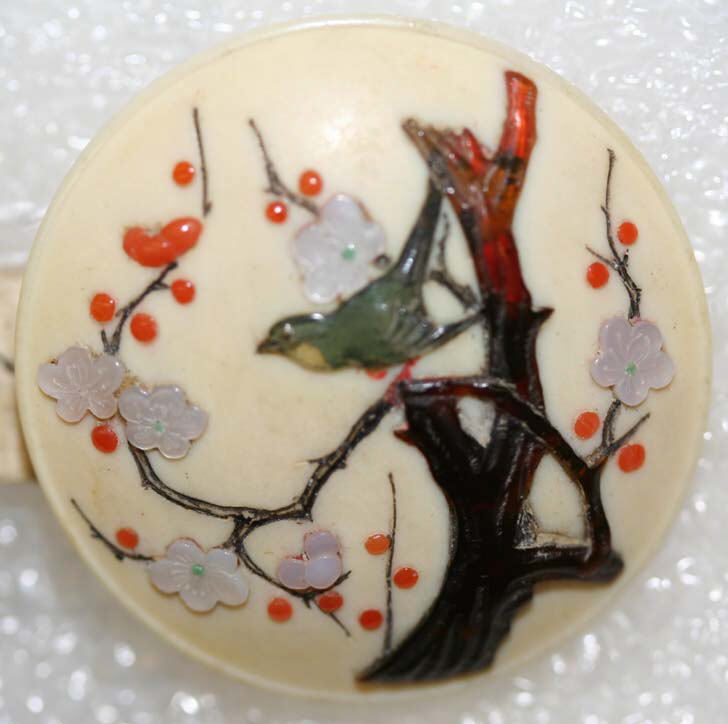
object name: button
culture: japanese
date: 1850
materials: coral, ivory, mother of pearl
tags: birds,flowers